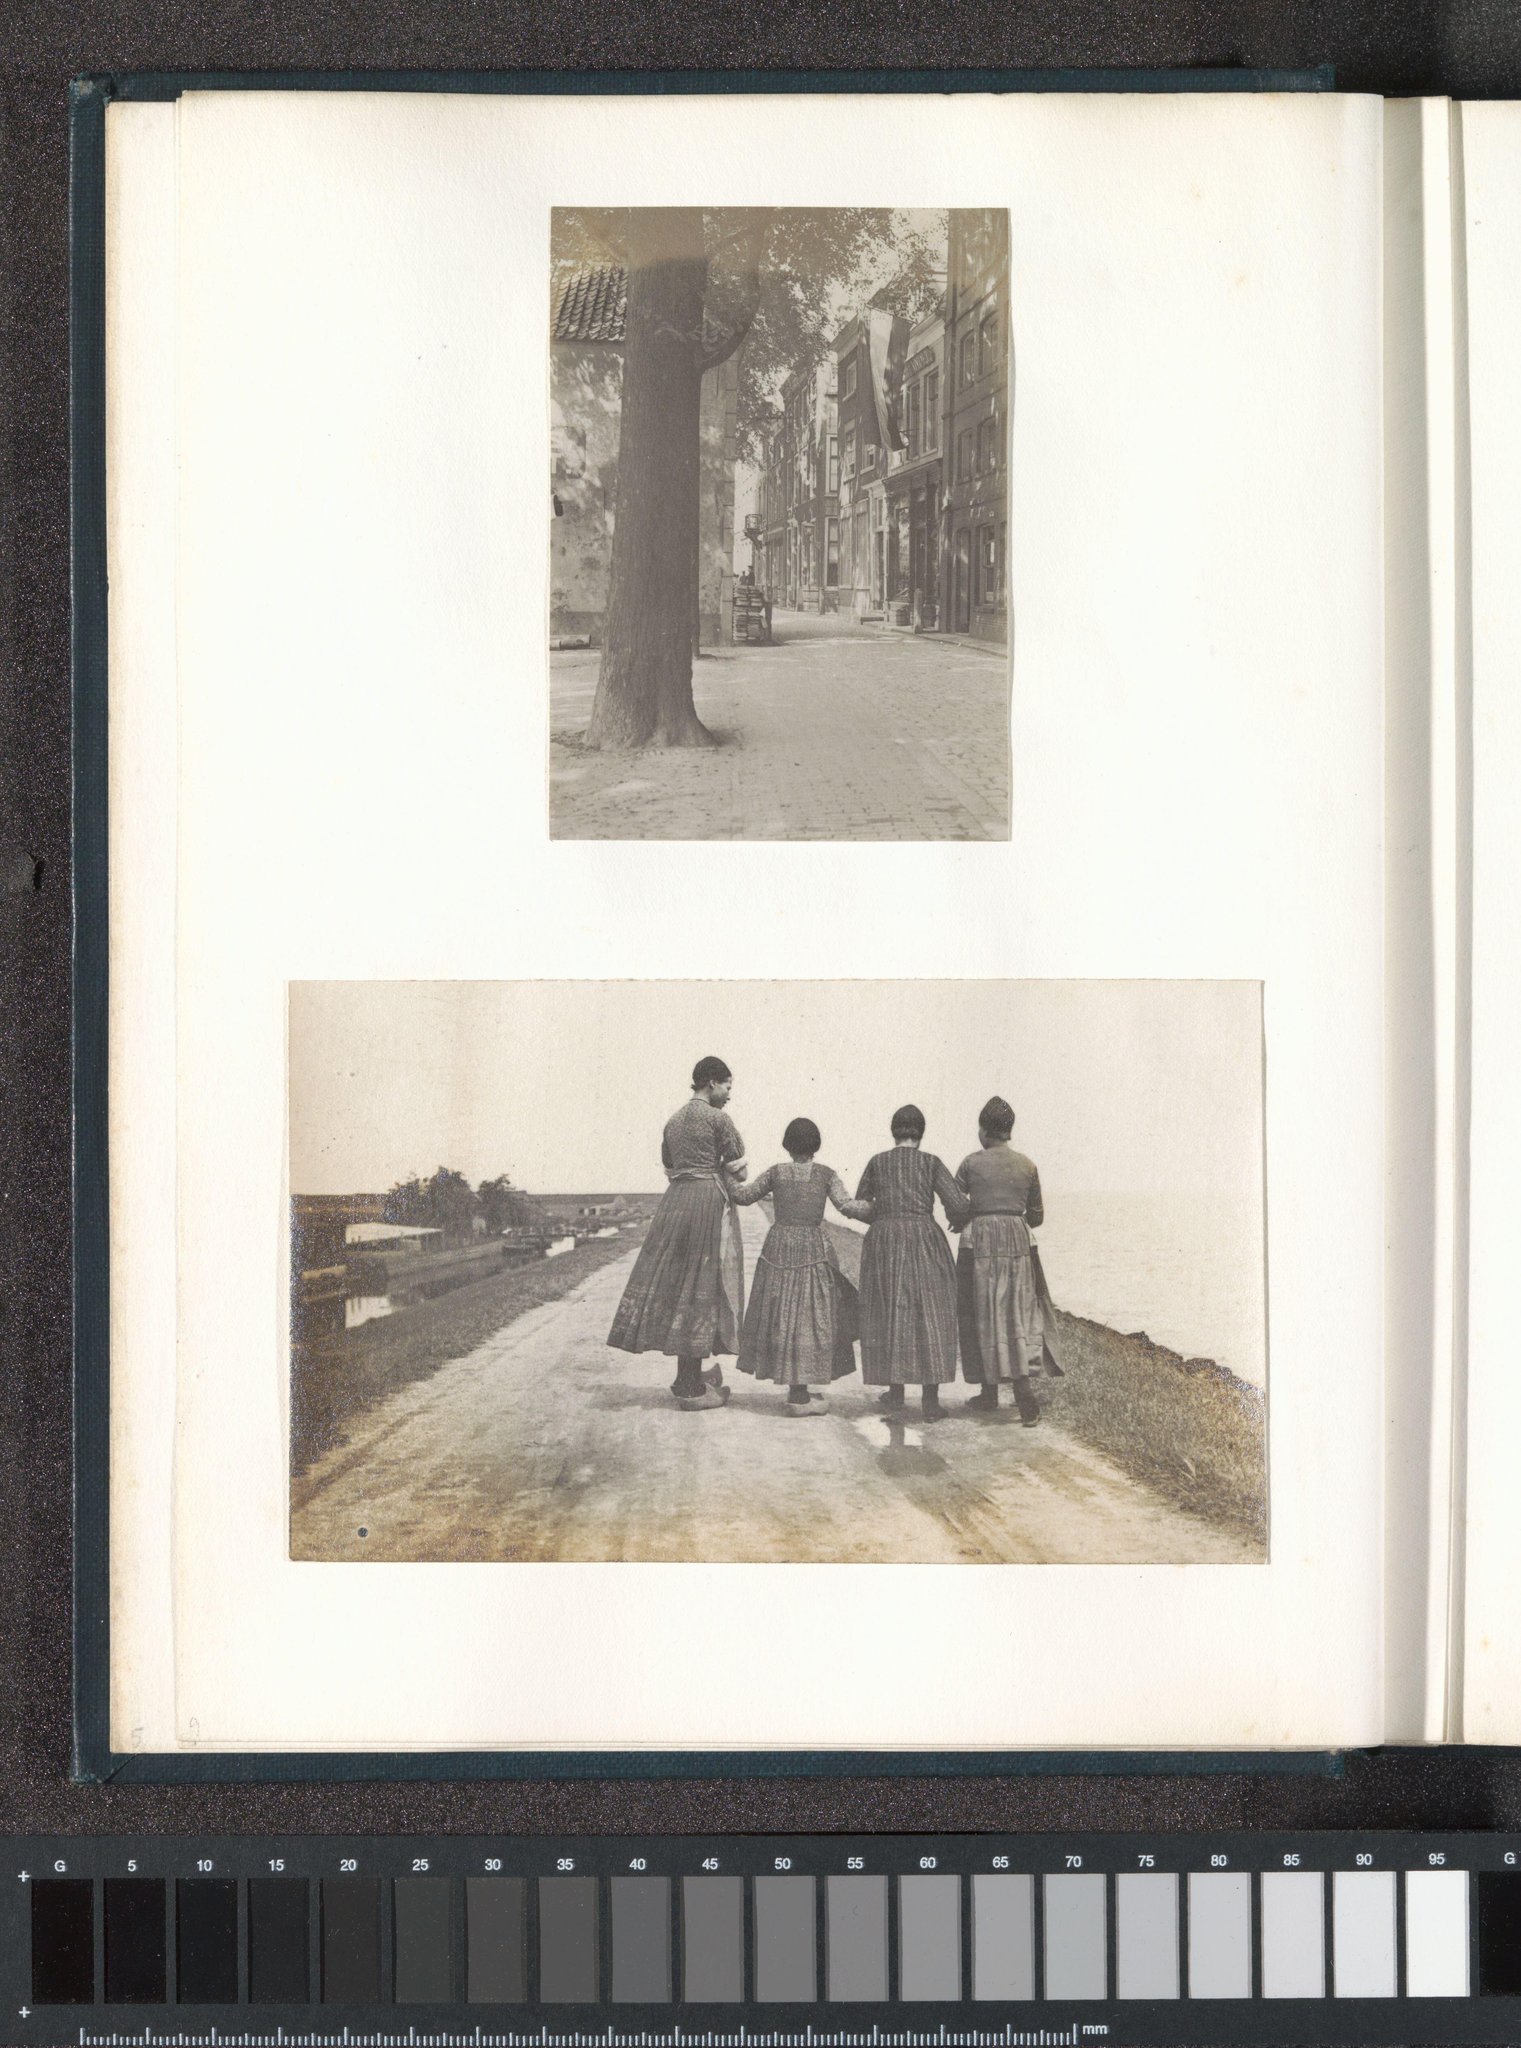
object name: photograph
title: Vier meisjes in Volendamse klederdracht op een dijk aan het water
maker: george hidderley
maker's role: fotograaf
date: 1900-1910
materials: paper, photographic support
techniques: gelatin silver print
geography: volendam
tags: folk costume, regional costume (+ women's clothes), adolescent, young woman, maiden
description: Onderdeel van fotoalbum met opnames van Volendam, Dordrecht, Gorinchem en Woudrichem.